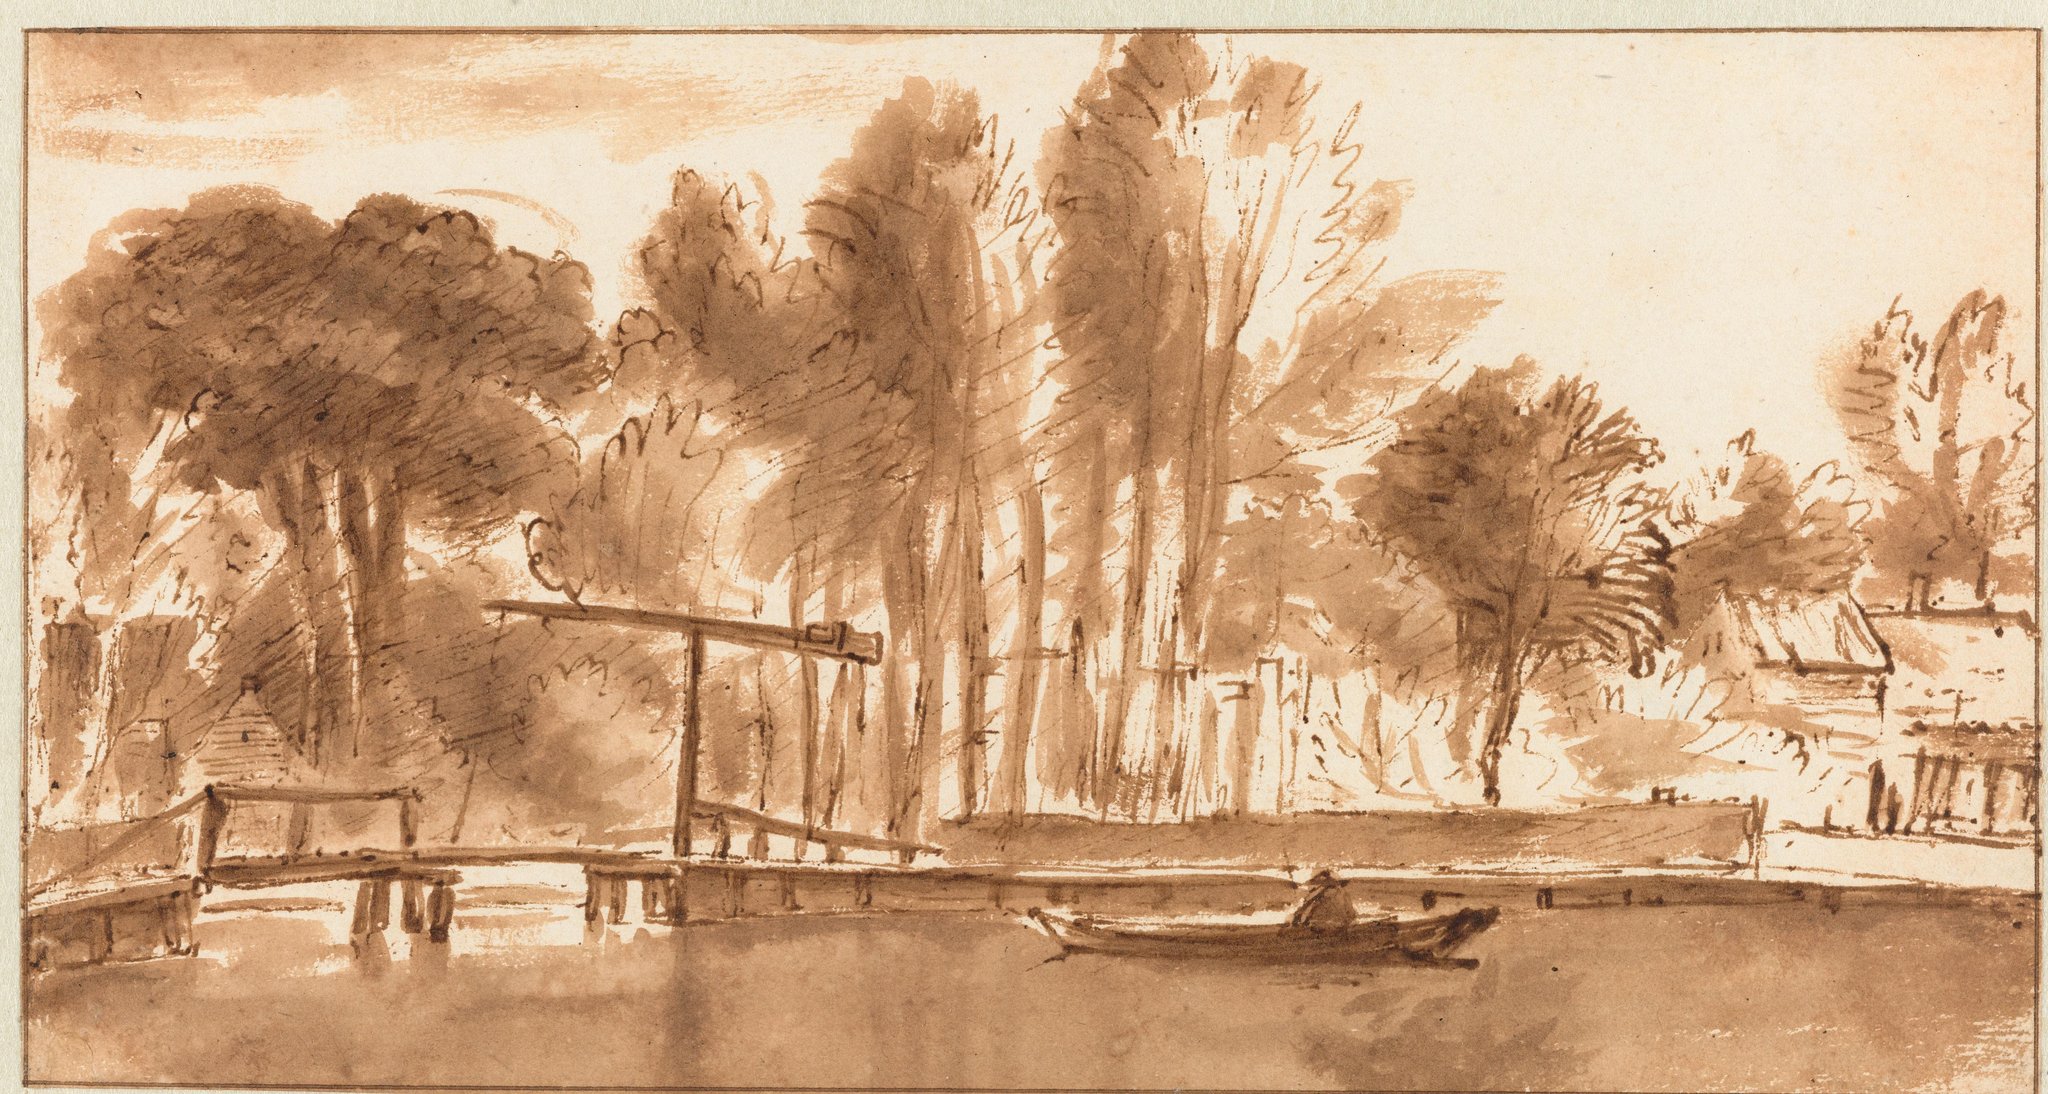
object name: drawing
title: Bebost rivierlandschap met ophaalbrug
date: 1631-1674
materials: ink, paper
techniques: brush, pen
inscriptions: date: ‘1648’